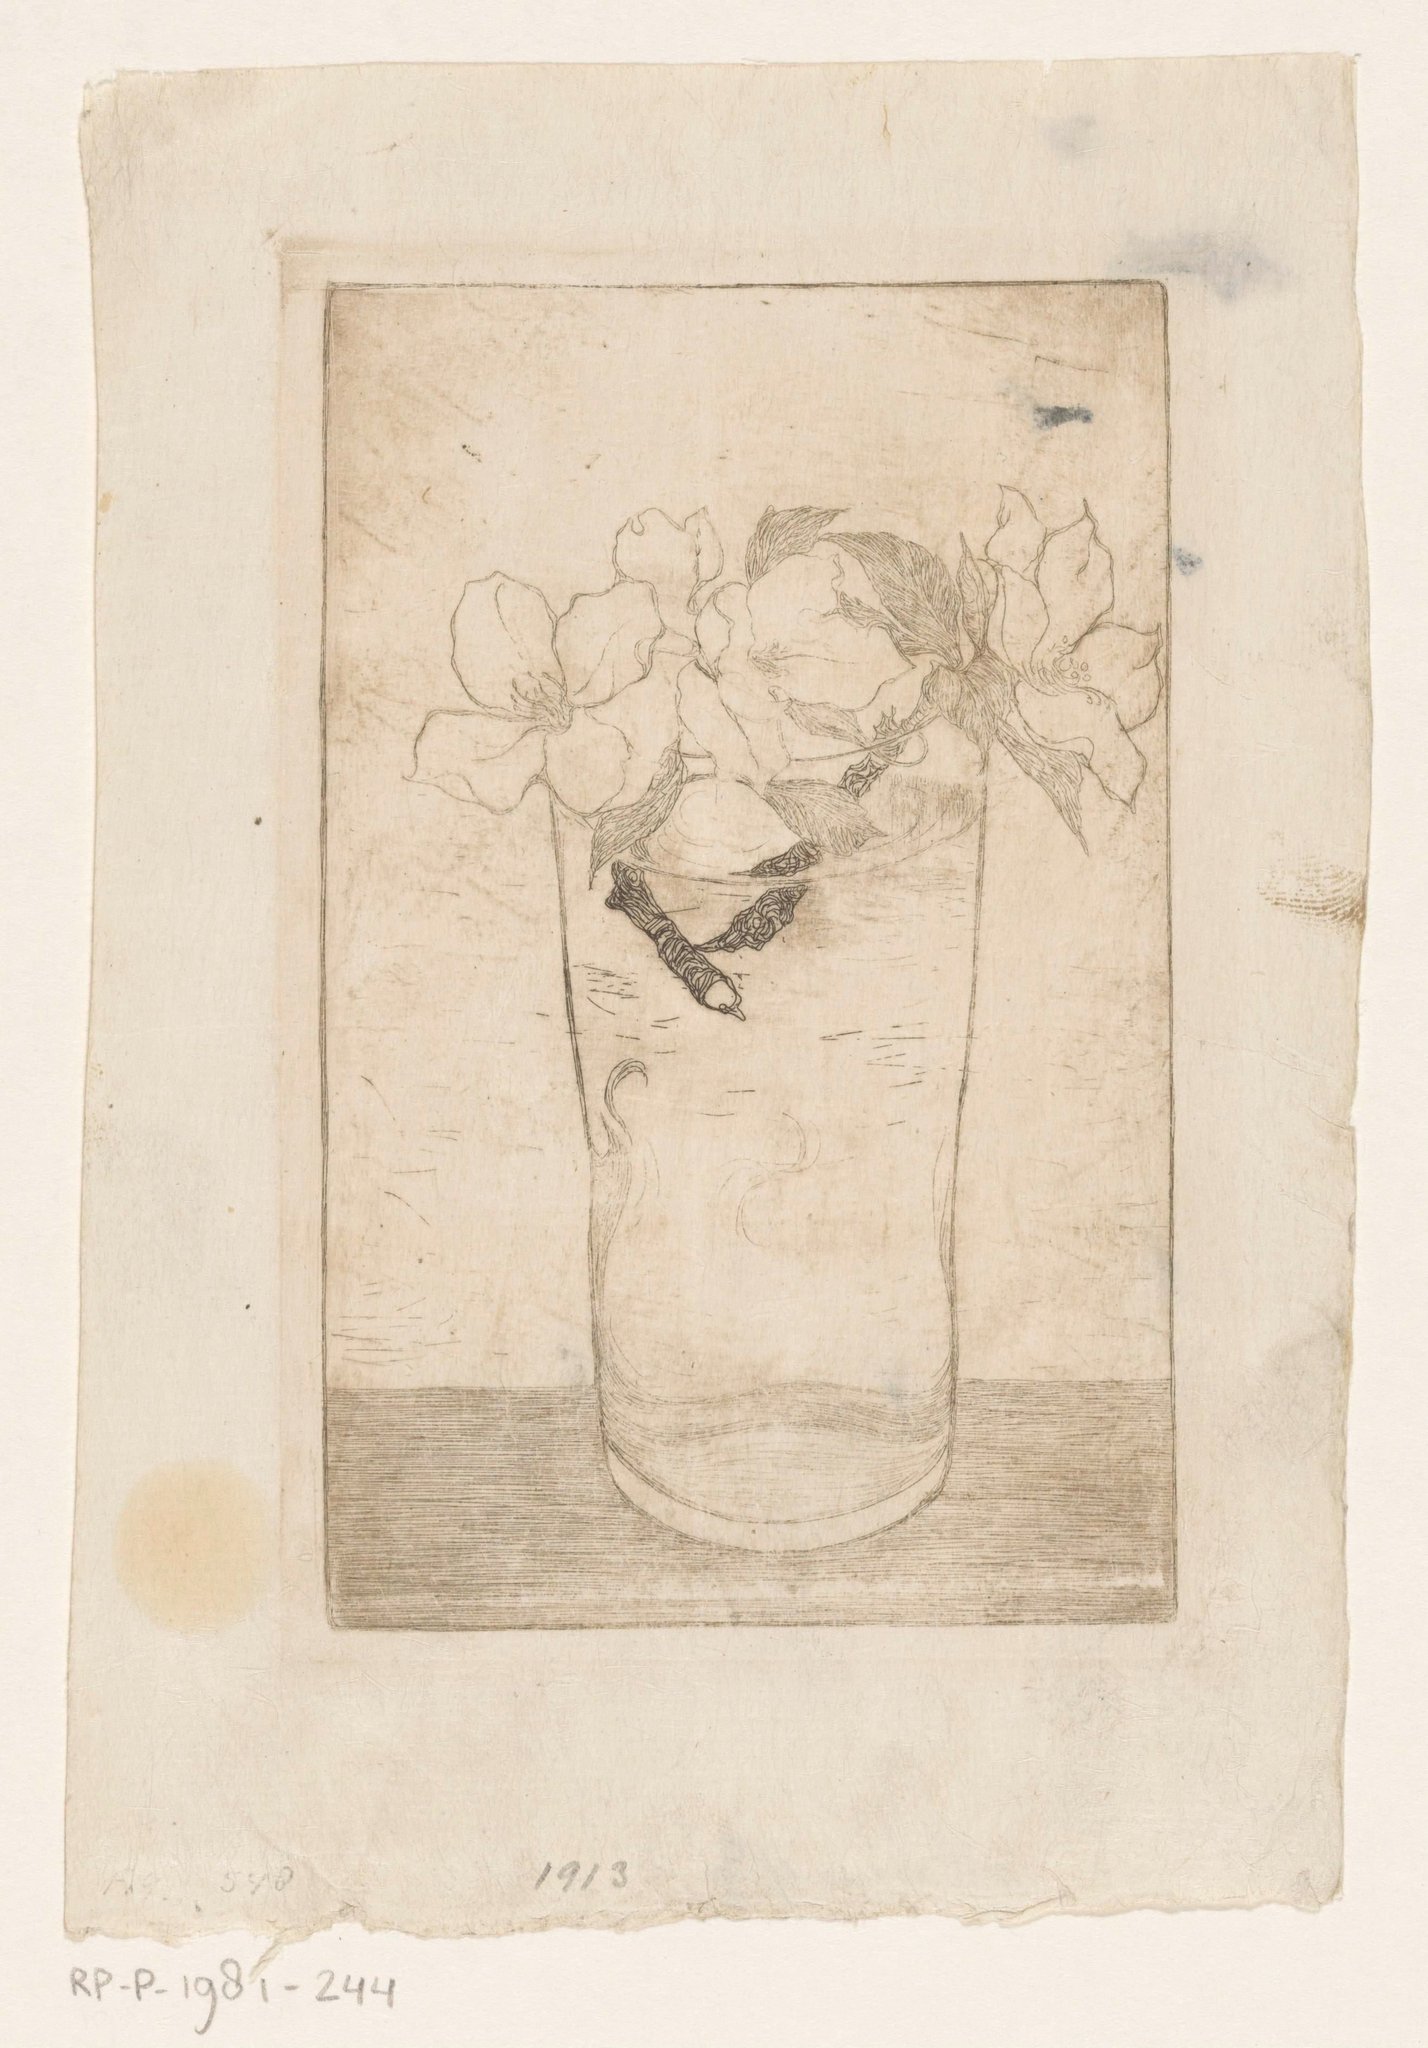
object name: print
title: Glas met bloesemtakken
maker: jan mankes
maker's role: draughtsman, painter, print maker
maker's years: 1889-1920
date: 1913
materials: paper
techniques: etching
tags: flowers, container of glass: bottle, jar, vase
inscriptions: collector's mark: Lugt 2228